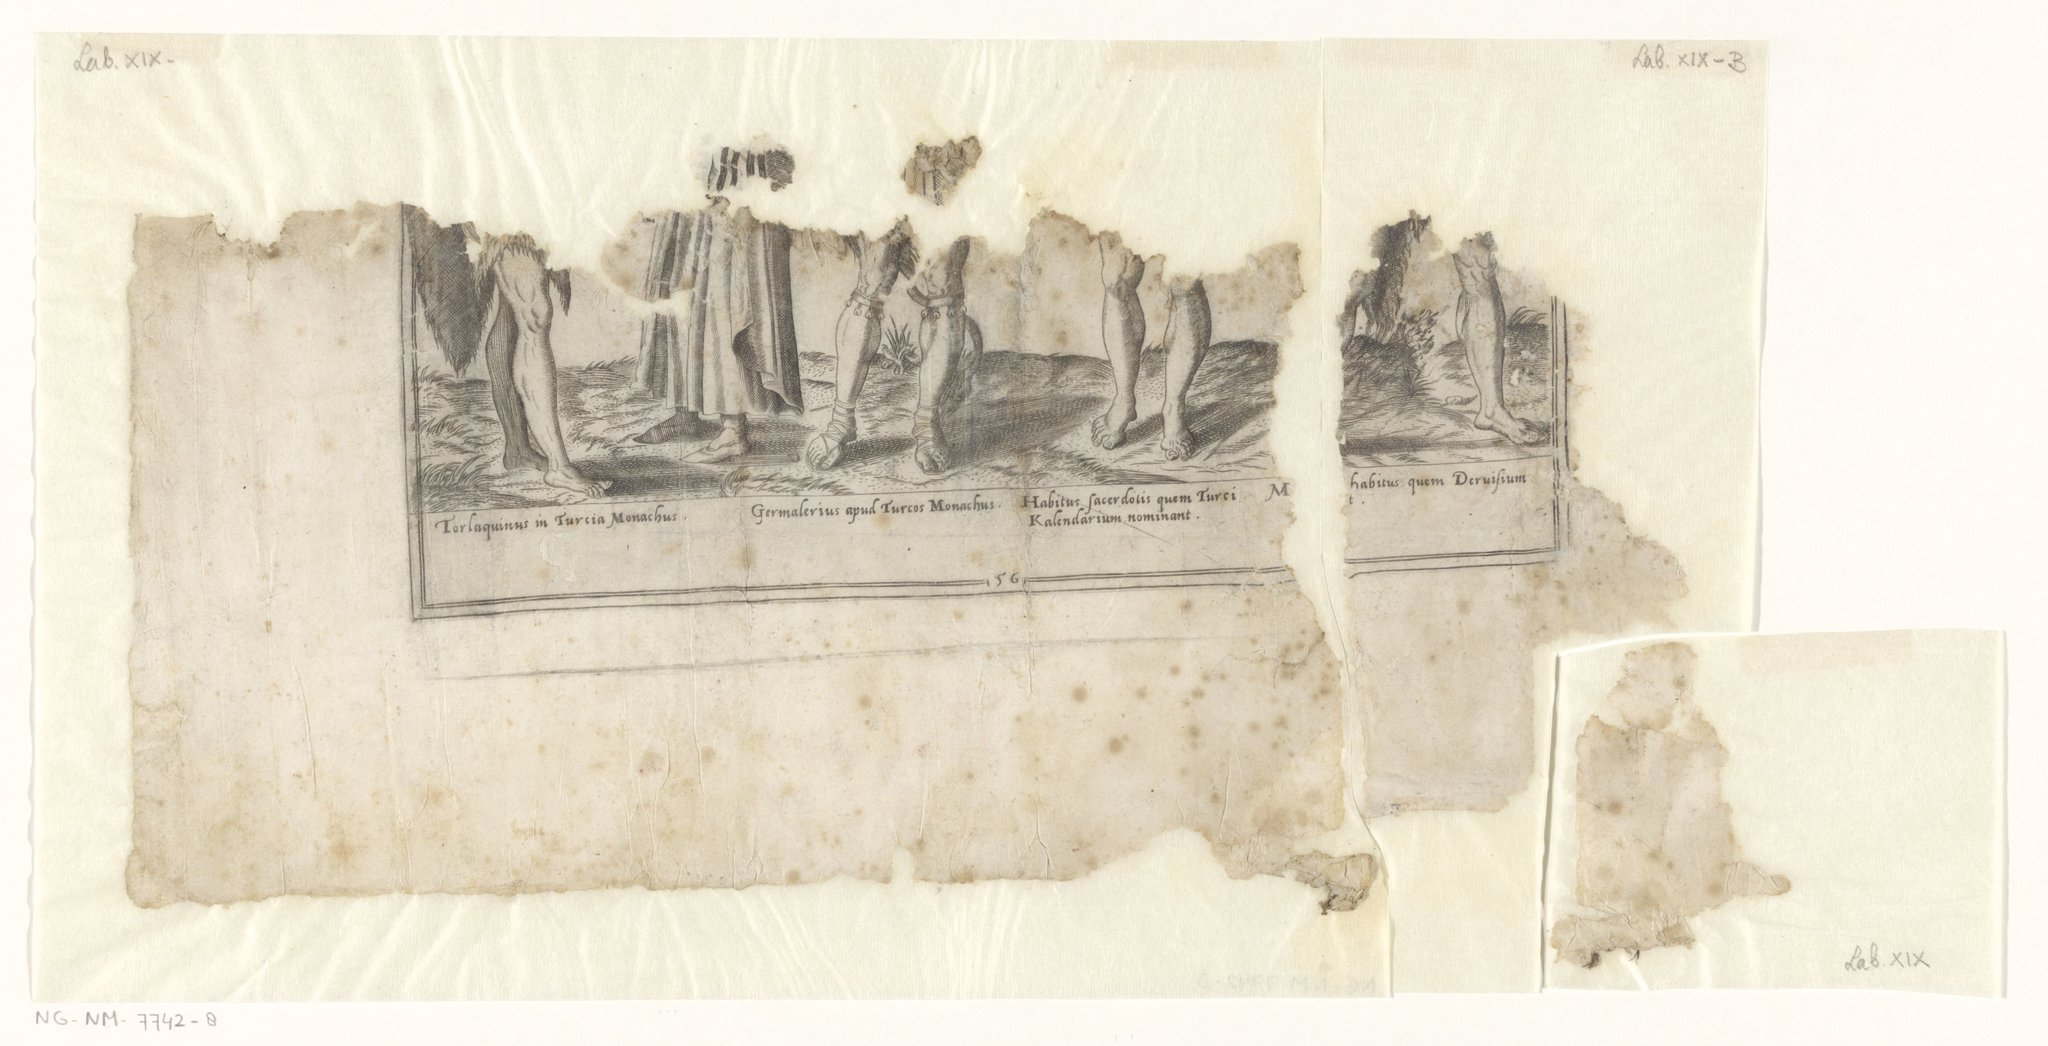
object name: print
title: Fragmenten van prenten met wereldlijke en geestelijke klederdrachten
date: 1581-1596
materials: paper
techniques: engraving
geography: cologne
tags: clothes, costume (+ women's clothes), clothes, costume (+ men's clothes)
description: De prenten in de Nova Zembla collectie zijn tijdens een expeditie van Willem Barendsz en Jacob van Heemskerk in 1596-1597 noodgedwongen in het winterkamp, het ‘Behouden Huis’, op het eiland achtergelaten. De prenten waren in één of meerdere stapels als handelswaar meegenomen vanuit Amsterdam. Bijna drie eeuwen later, in 1871, keerde de Noor Elling Carlsen terug naar Nova Zembla en vond daar de restanten van het ‘Behouden Huis, inclusief een groot deel van de inventaris. Een deel van de prenten, in de vorm van aaneengekoekte kluiten, werd toen ook teruggevonden. De papierkluiten waren soms op meerdere plekken gebroken. Tussen 1975-1979 zijn de prenten van elkaar gescheiden. Dit leverde in totaal ca. 1000 fragmenten van ca. 400 afdrukken van ca. 150 verschillende prenten op. Voor zover mogelijk zijn de fragmenten samengevoegd en zijn de prenten gereconstrueerd.